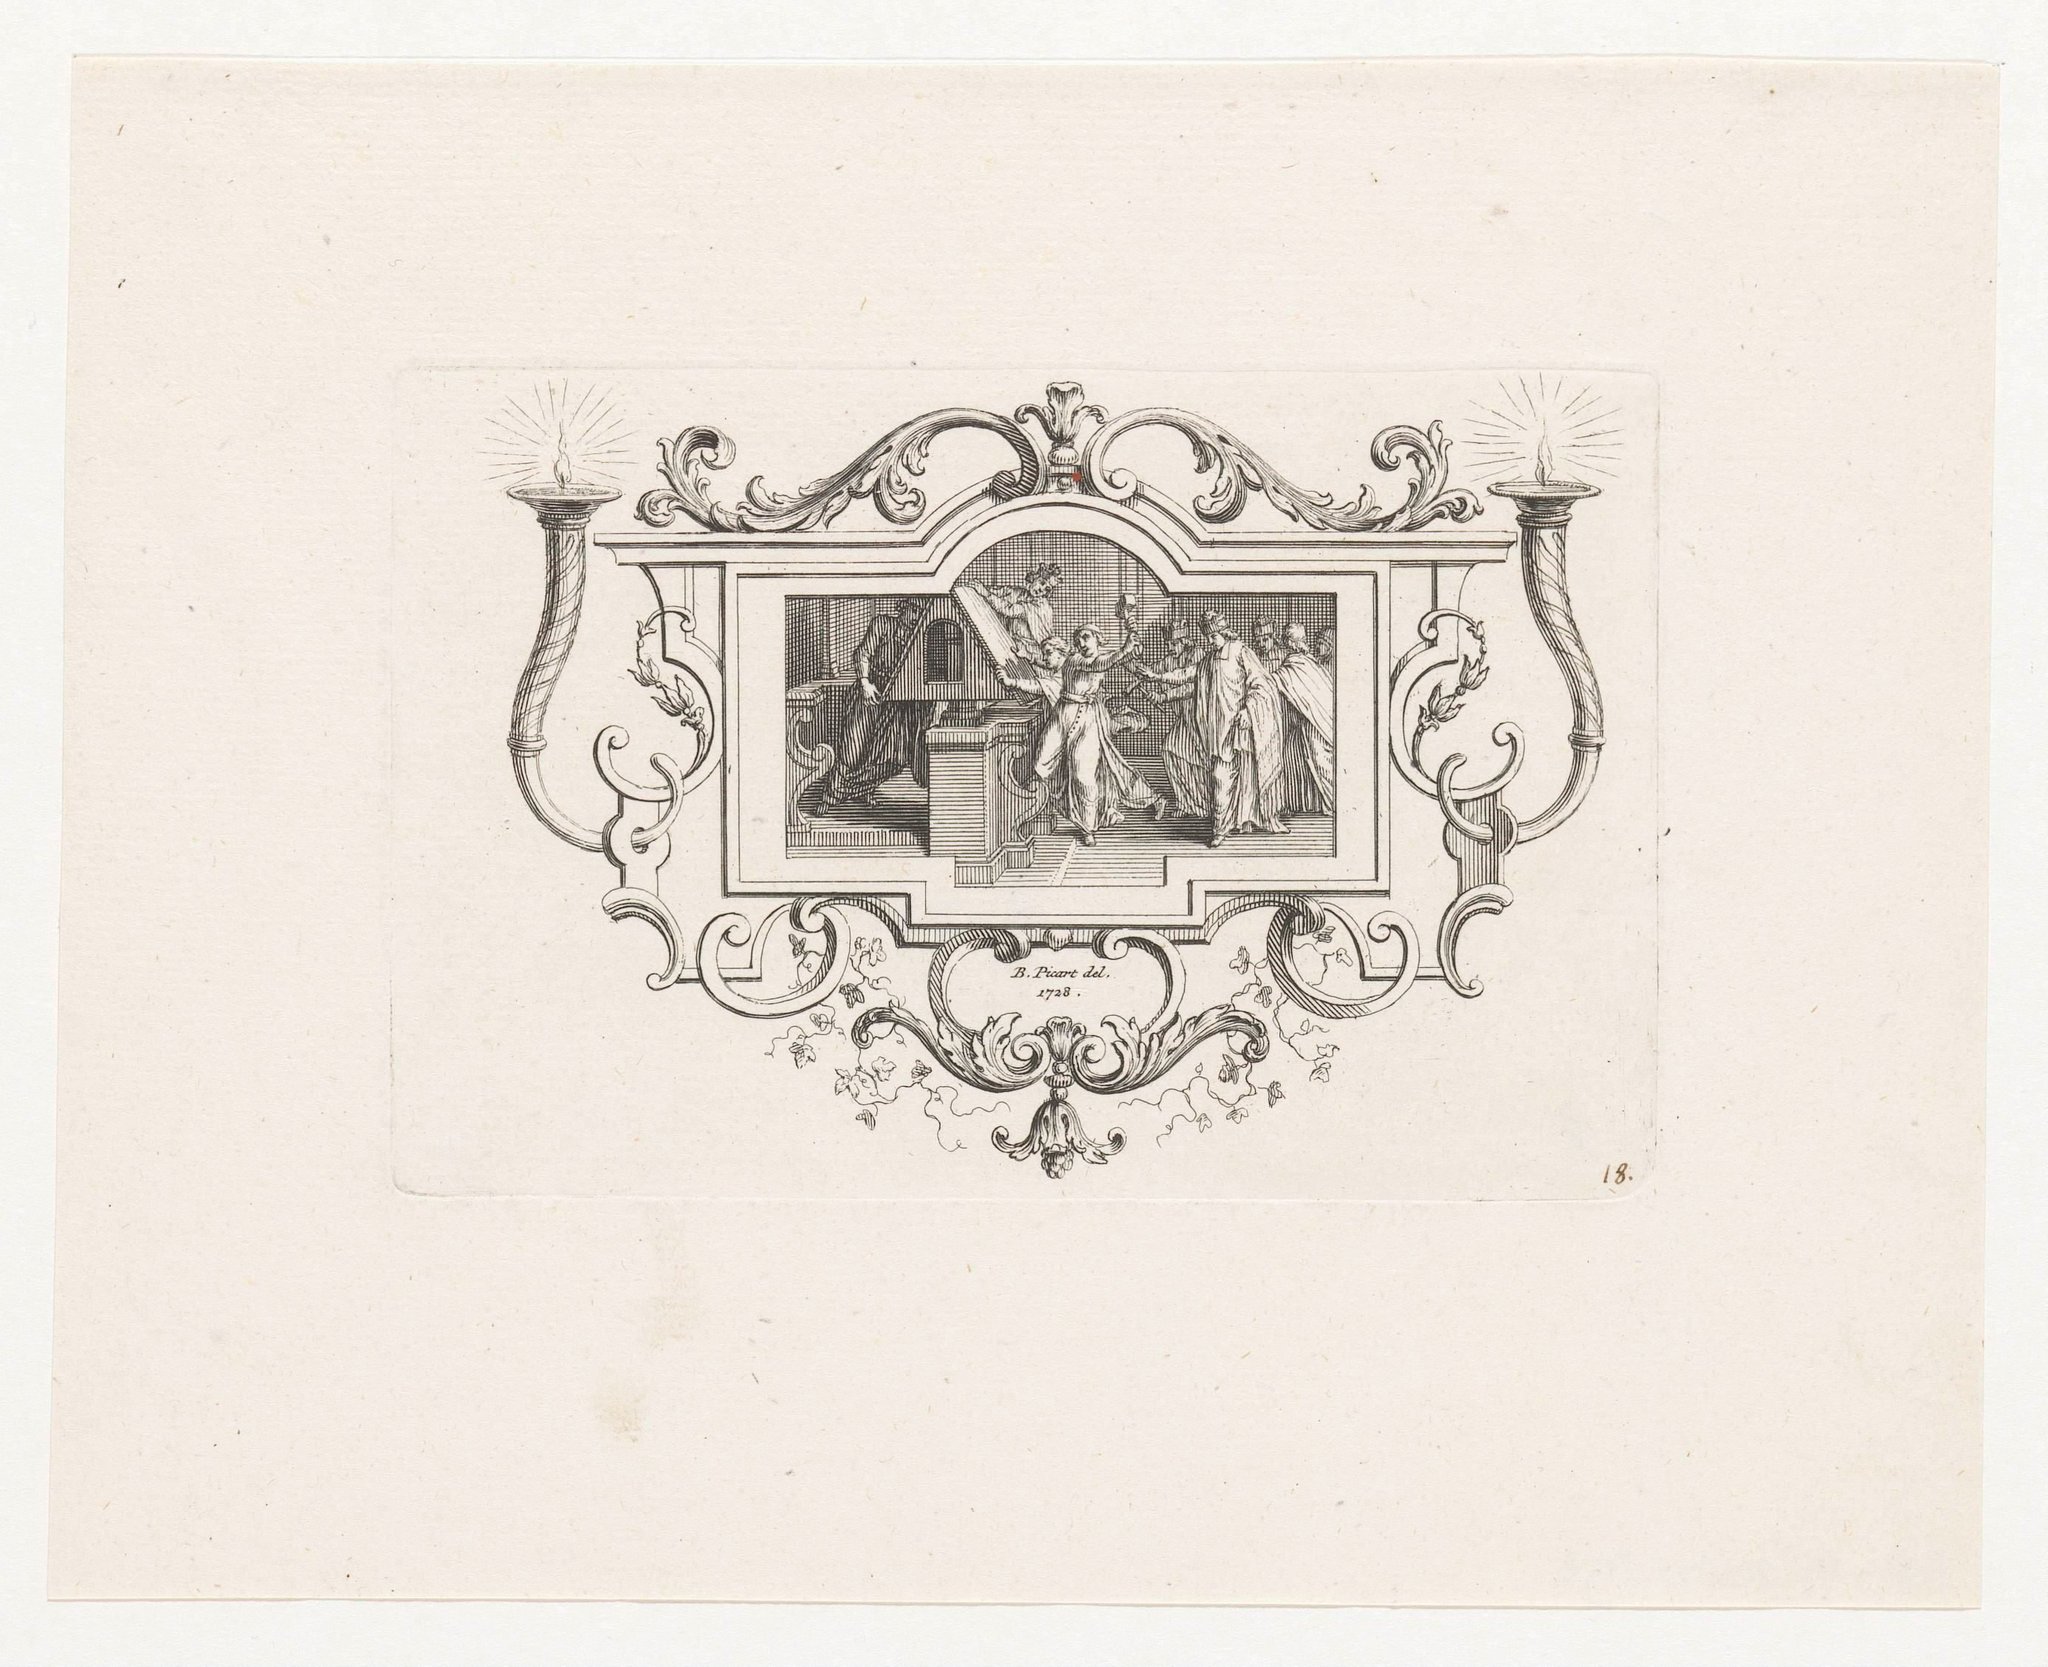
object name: print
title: Geestelijken verwoesten een lessenaar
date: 1728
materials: paper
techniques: engraving, etching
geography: amsterdam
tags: nicolas boileau, (liturgical) equipment of church, ornaments ~ art, destruction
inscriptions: number: ‘18.’, collector's mark: Lugt 2228, inscription: ‘[A]P 304’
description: Prent mogelijk gebruikt in: Boileau-Despréaux, Nicolas. Oeuvres. Amsterdam: François Changuion, Den Haag, Pieter de Hondt, 1729. Nummer 7 in: Explication des Vignettes de la Seconde Edition des Oeuvres de Boileau. Amsterdam: Bernard Picart, 1729.